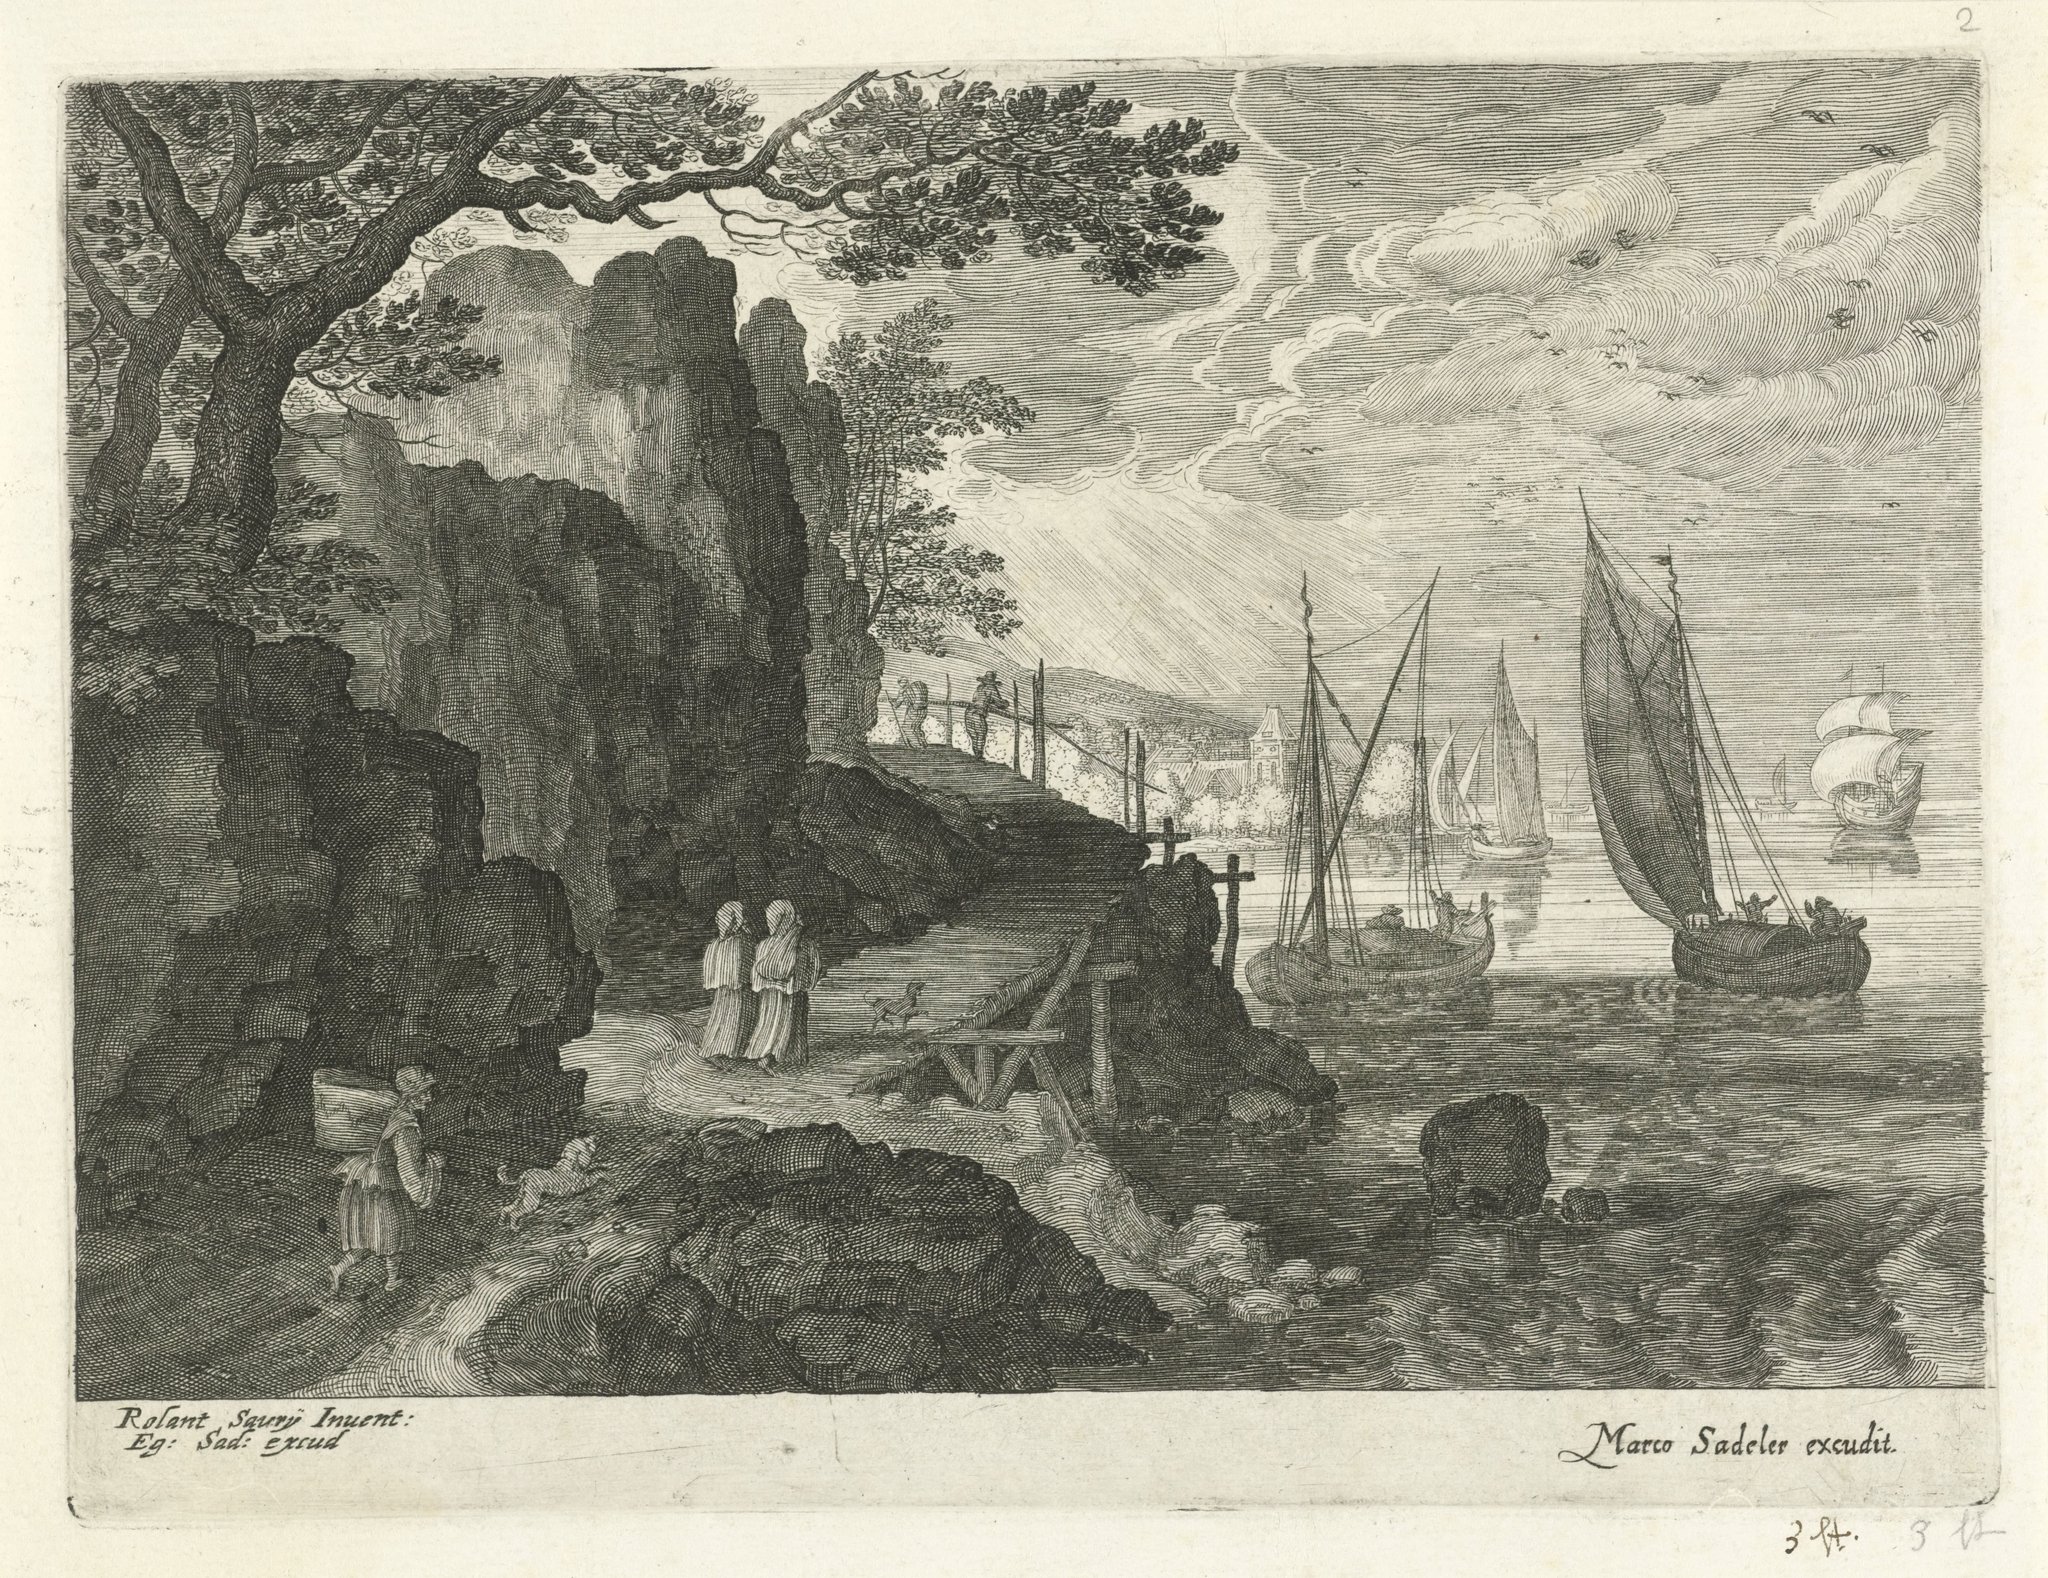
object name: print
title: Landschappen uit Tirol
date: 1580-1629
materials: paper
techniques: engraving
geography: prague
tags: harbour, road, path, river (+ landscape with figures, staffage)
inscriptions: collector's mark: Lugt 2228, inscription: ‘3ft.’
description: Gezicht op een haven in rotsachtig landschap. Links een landweg met reizigers en een hond. De tweede prent van een zesdelige reeks met landschappen uit Tirol.